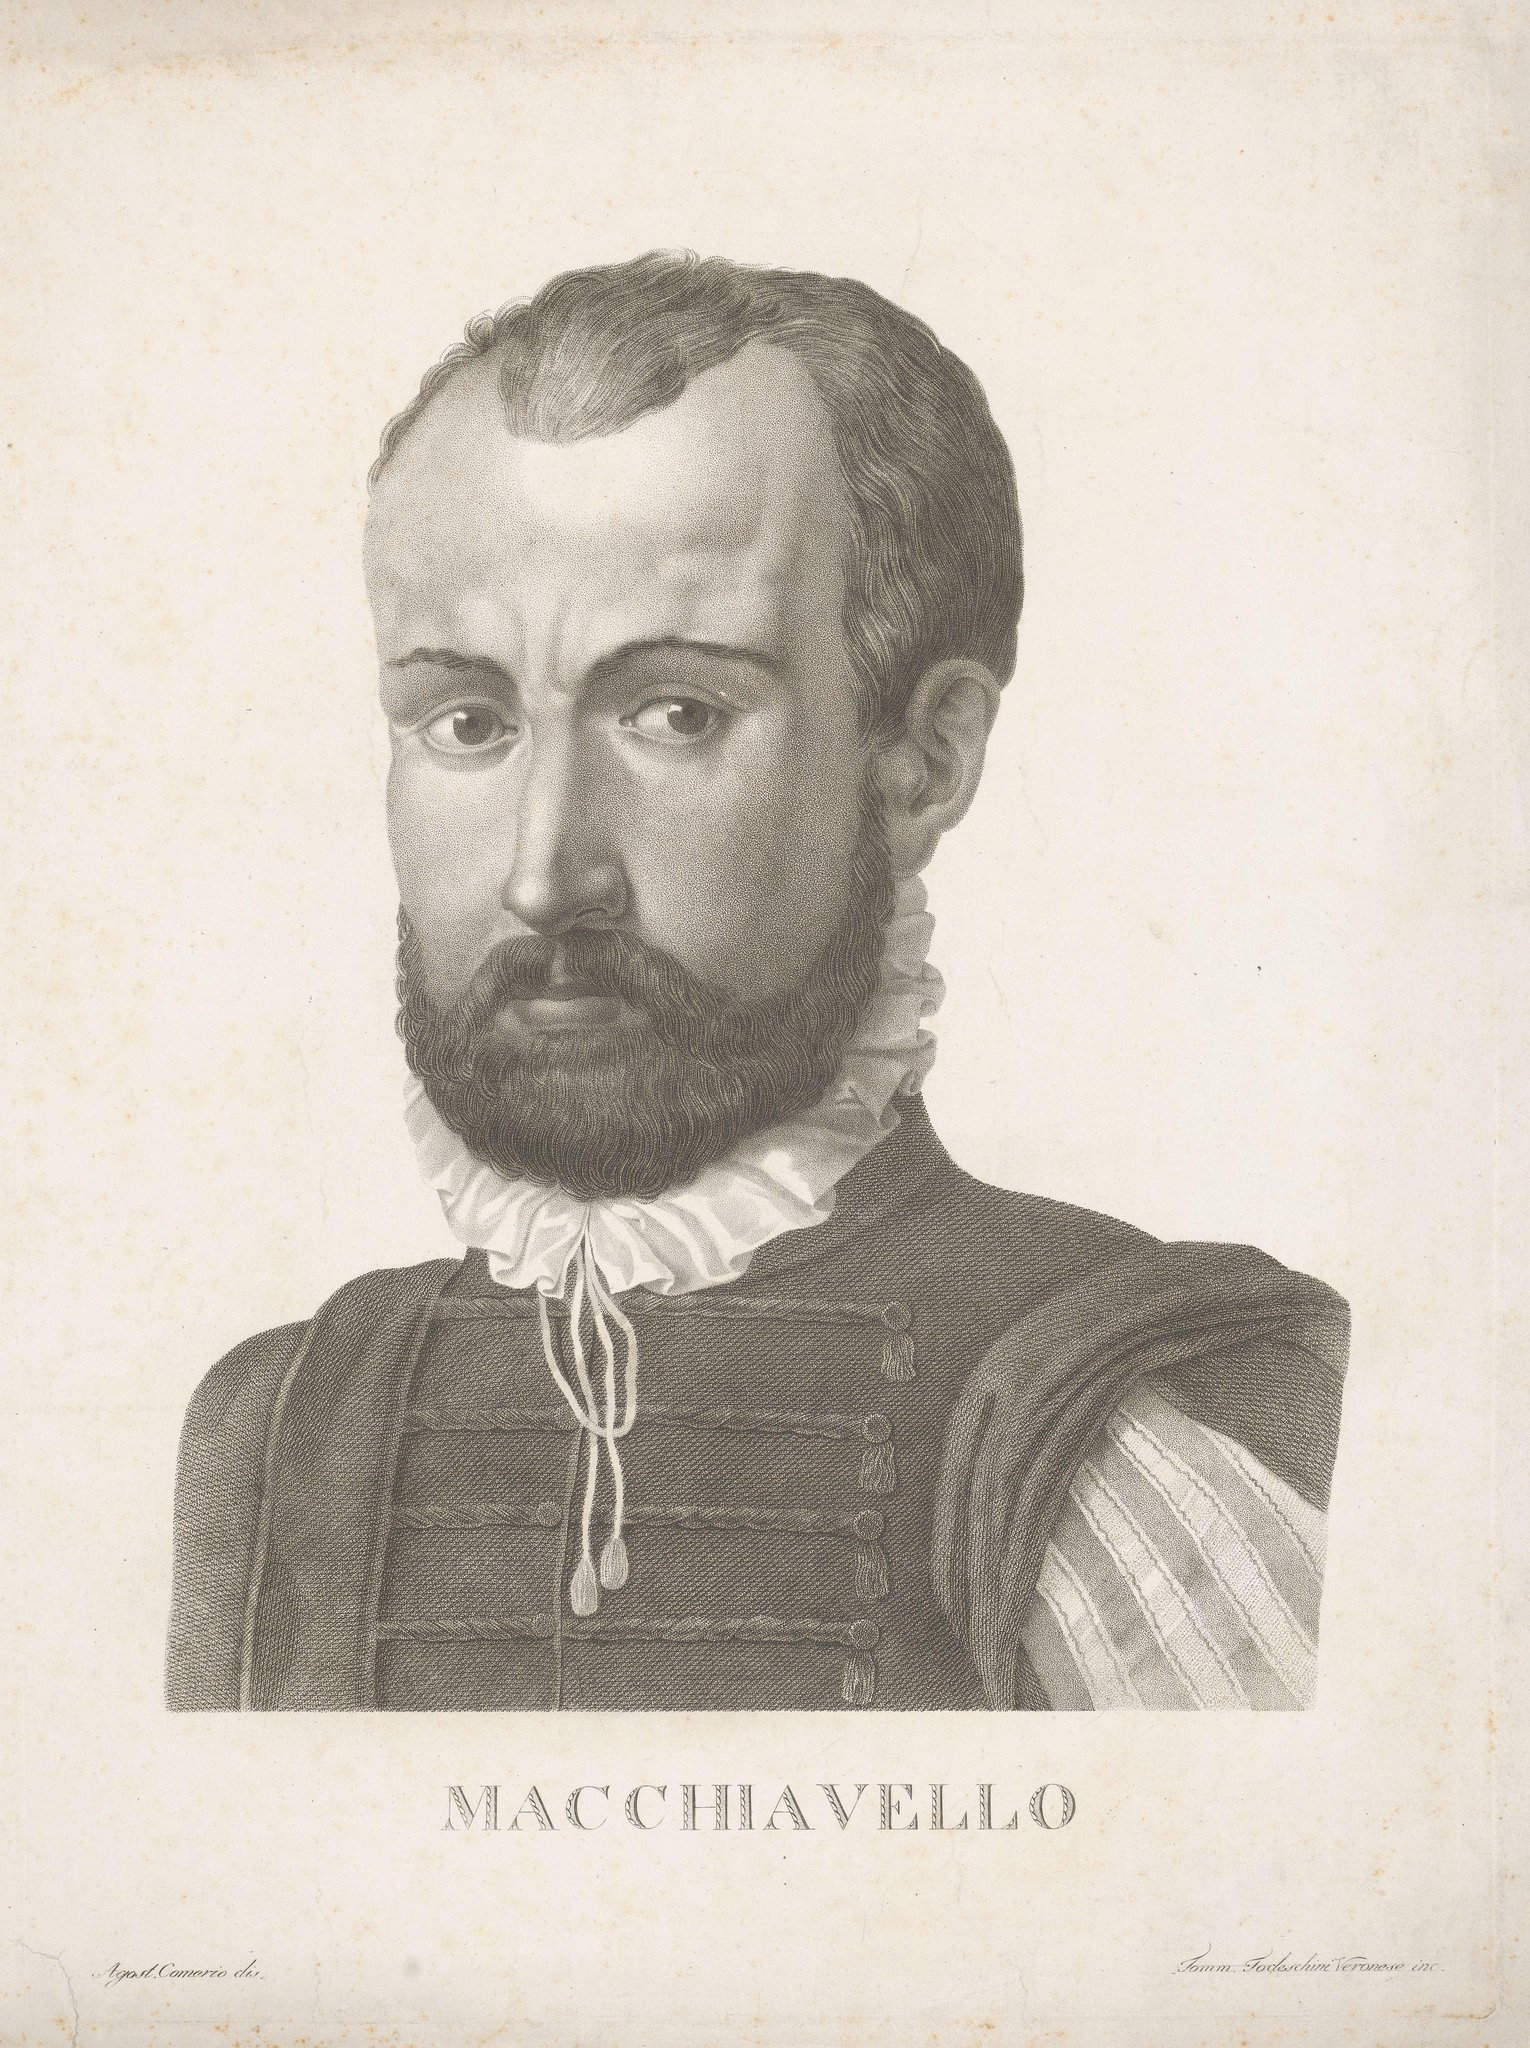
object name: print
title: Portret van Niccolò Machiavelli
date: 1800-1899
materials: paper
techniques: engraving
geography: italy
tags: politician, historical persons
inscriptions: collector's mark: Lugt 2228